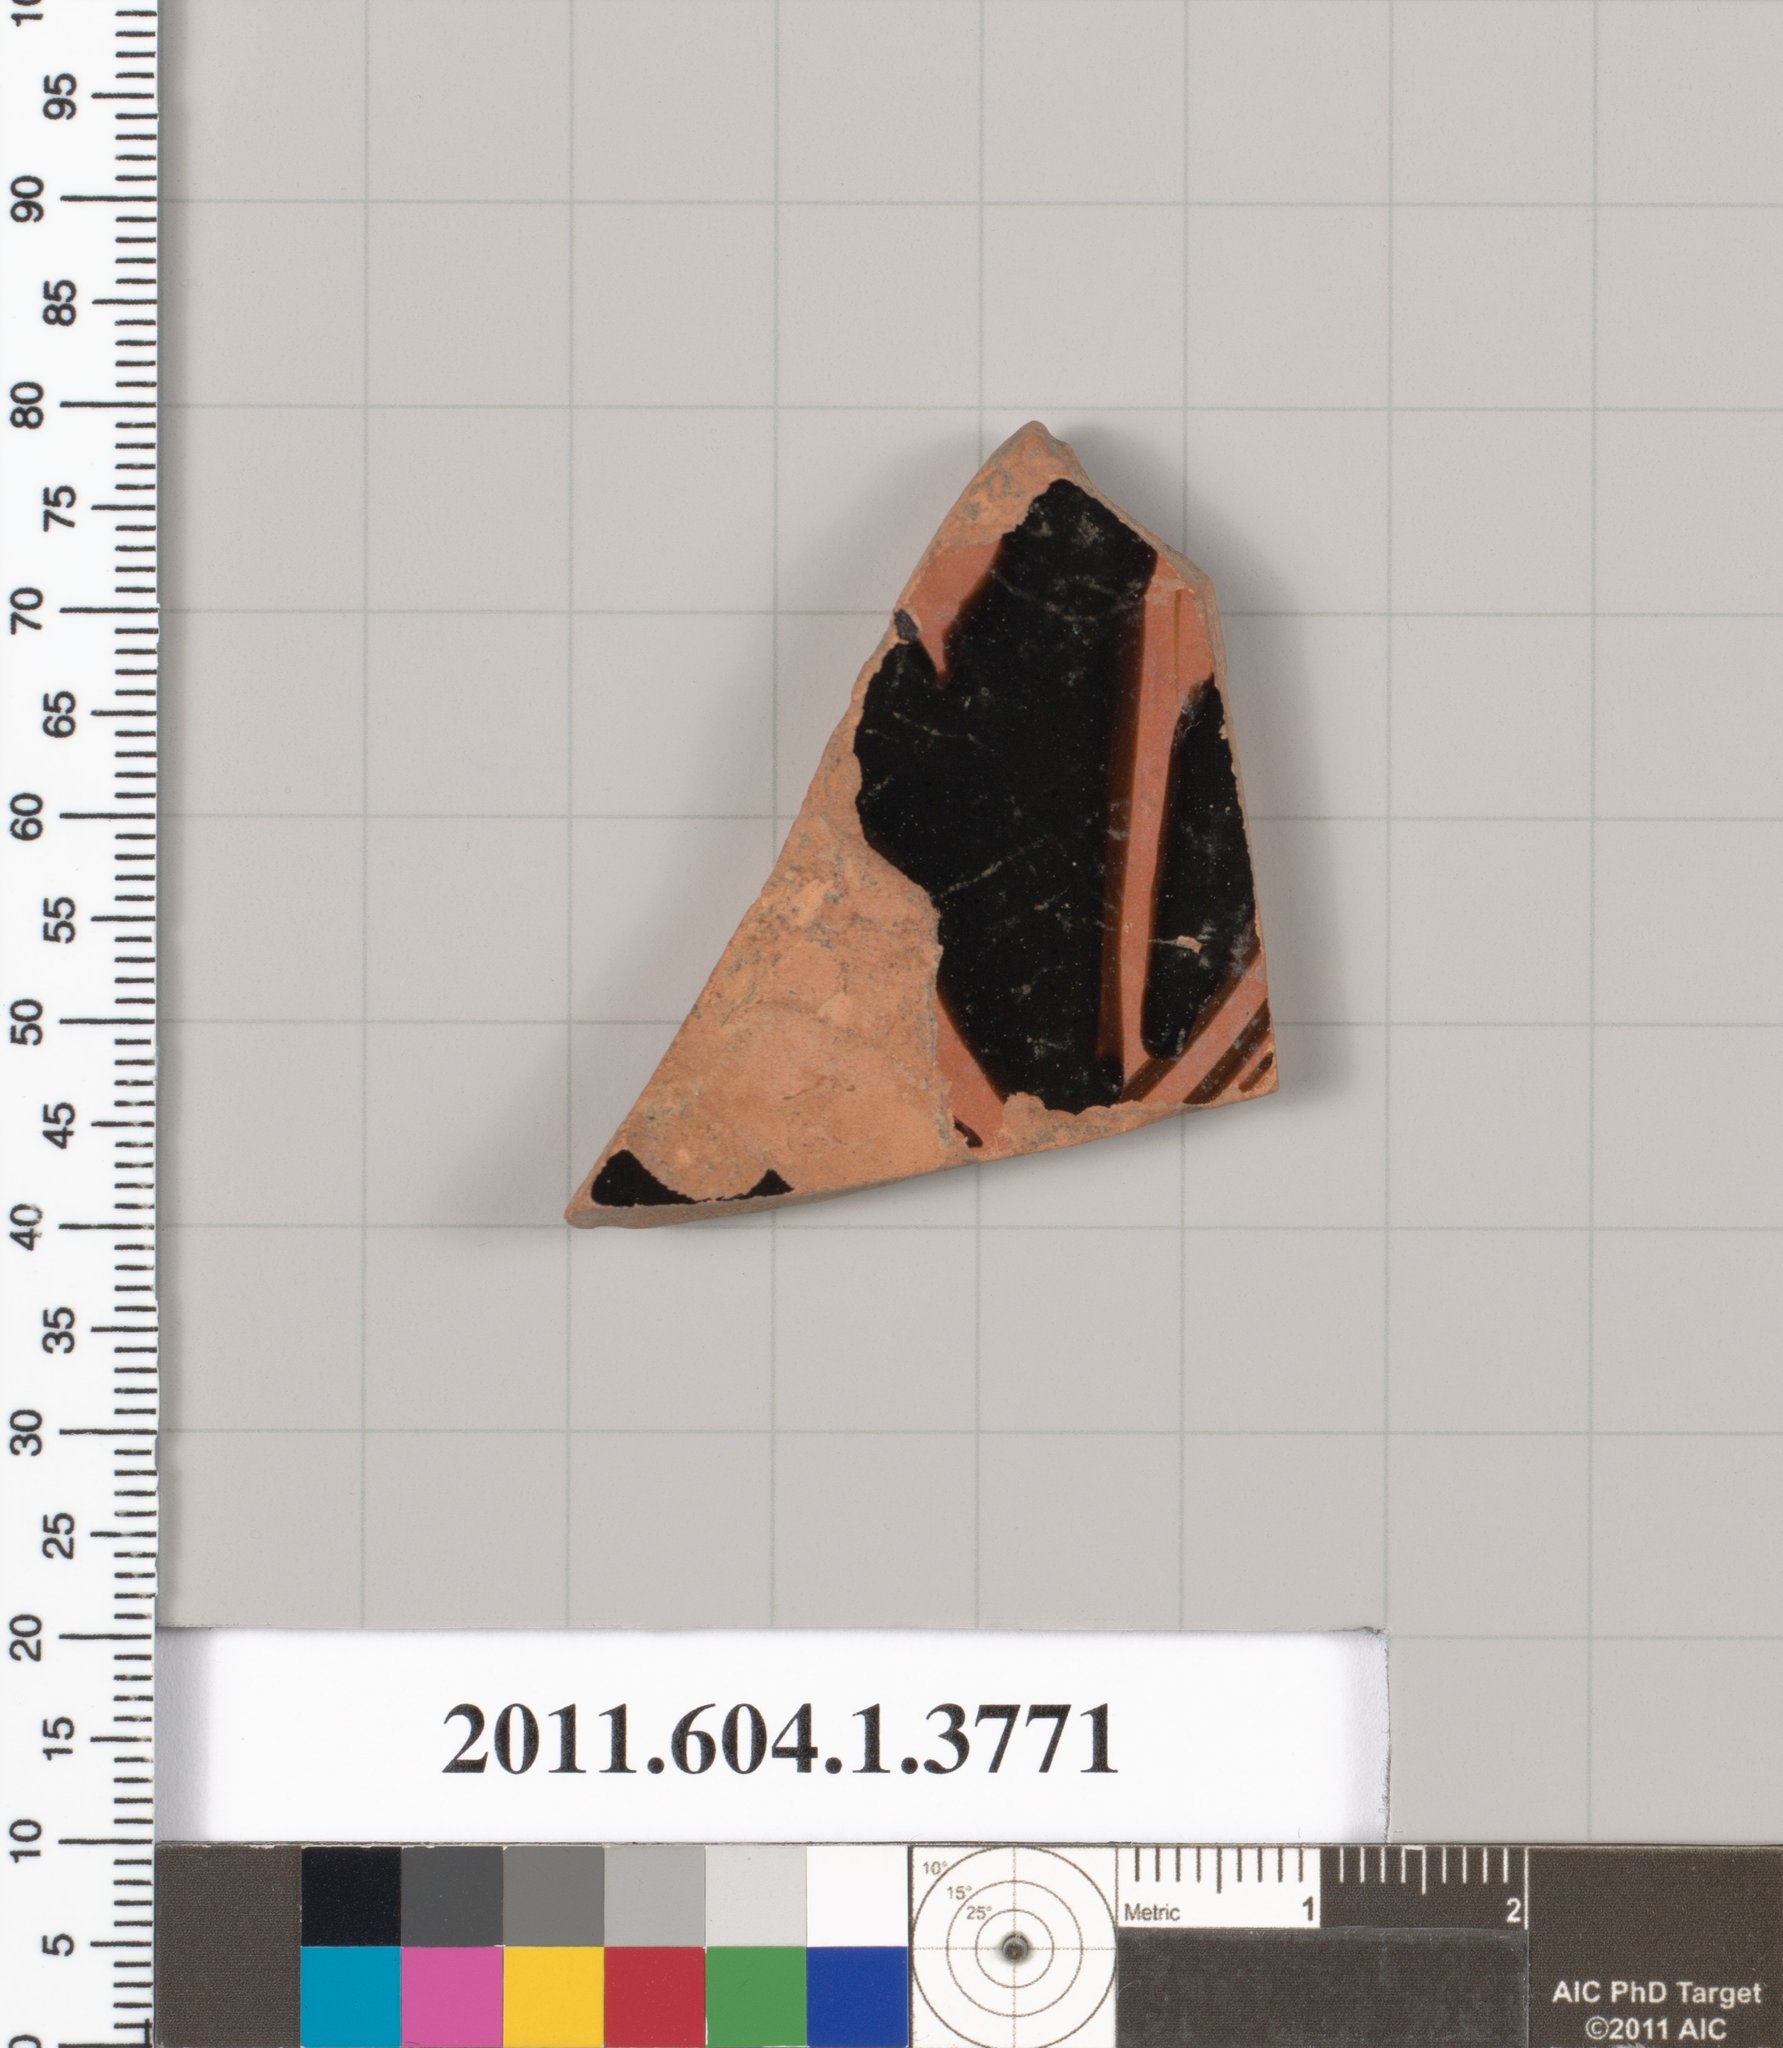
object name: kylix fragment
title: Terracotta fragment of a kylix (drinking cup)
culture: greek, attic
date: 475-451 BCE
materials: terracotta